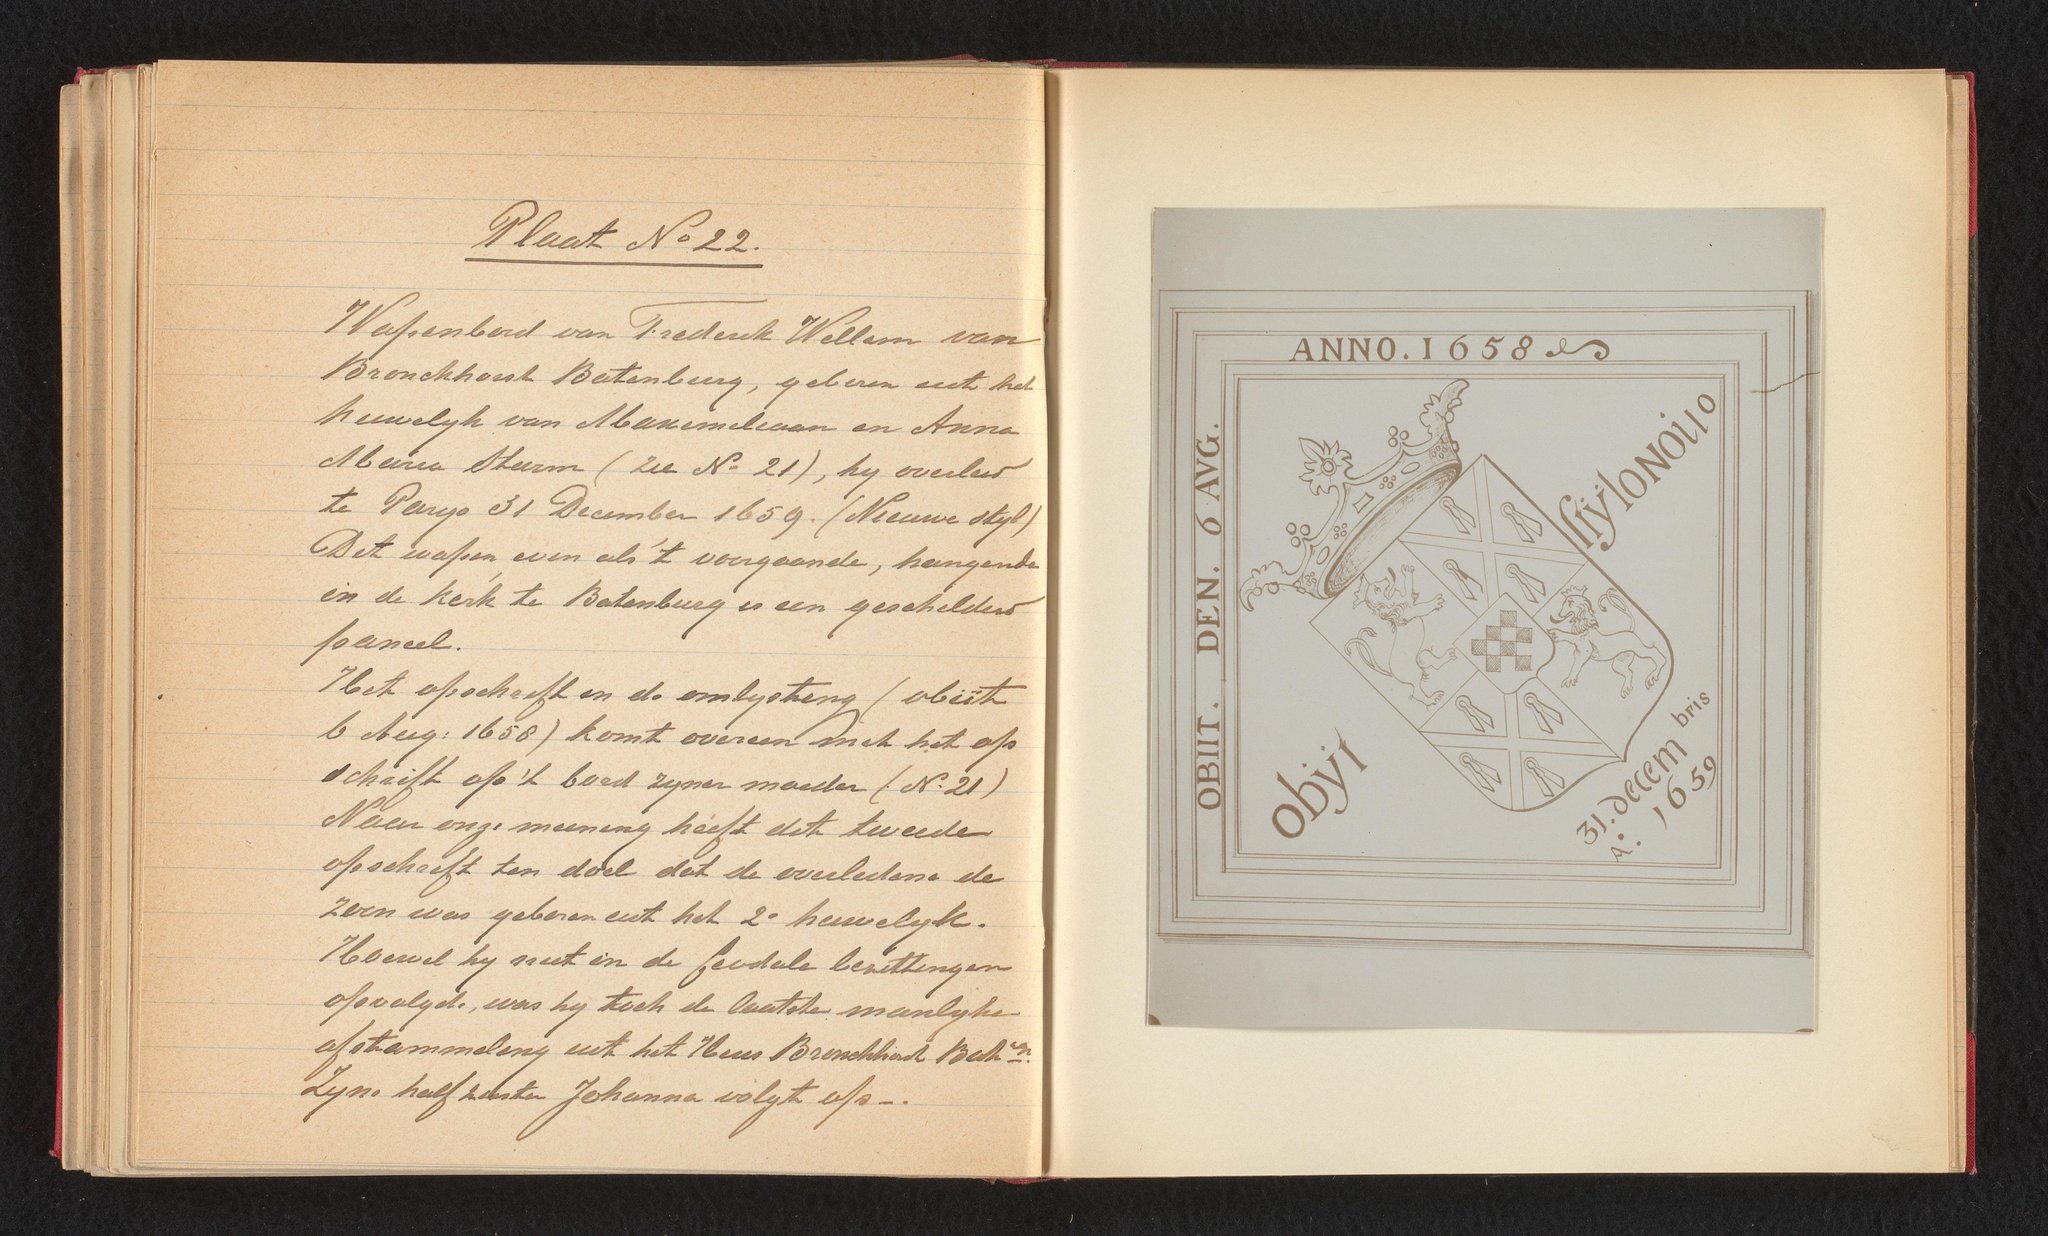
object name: photograph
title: Fotoreproductie van een getekend wapenbord van Frederik Willem van Bronckhorst-Batenburg-Steyn in de Oude Sint-Victorkerk in Batenburg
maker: benjamin charlé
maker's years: 1845-1925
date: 1902-1907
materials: paper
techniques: collodion silver print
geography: batenburg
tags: paris, armorial bearing, heraldry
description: Foto op zesentachtigste ongenummerde pagina.